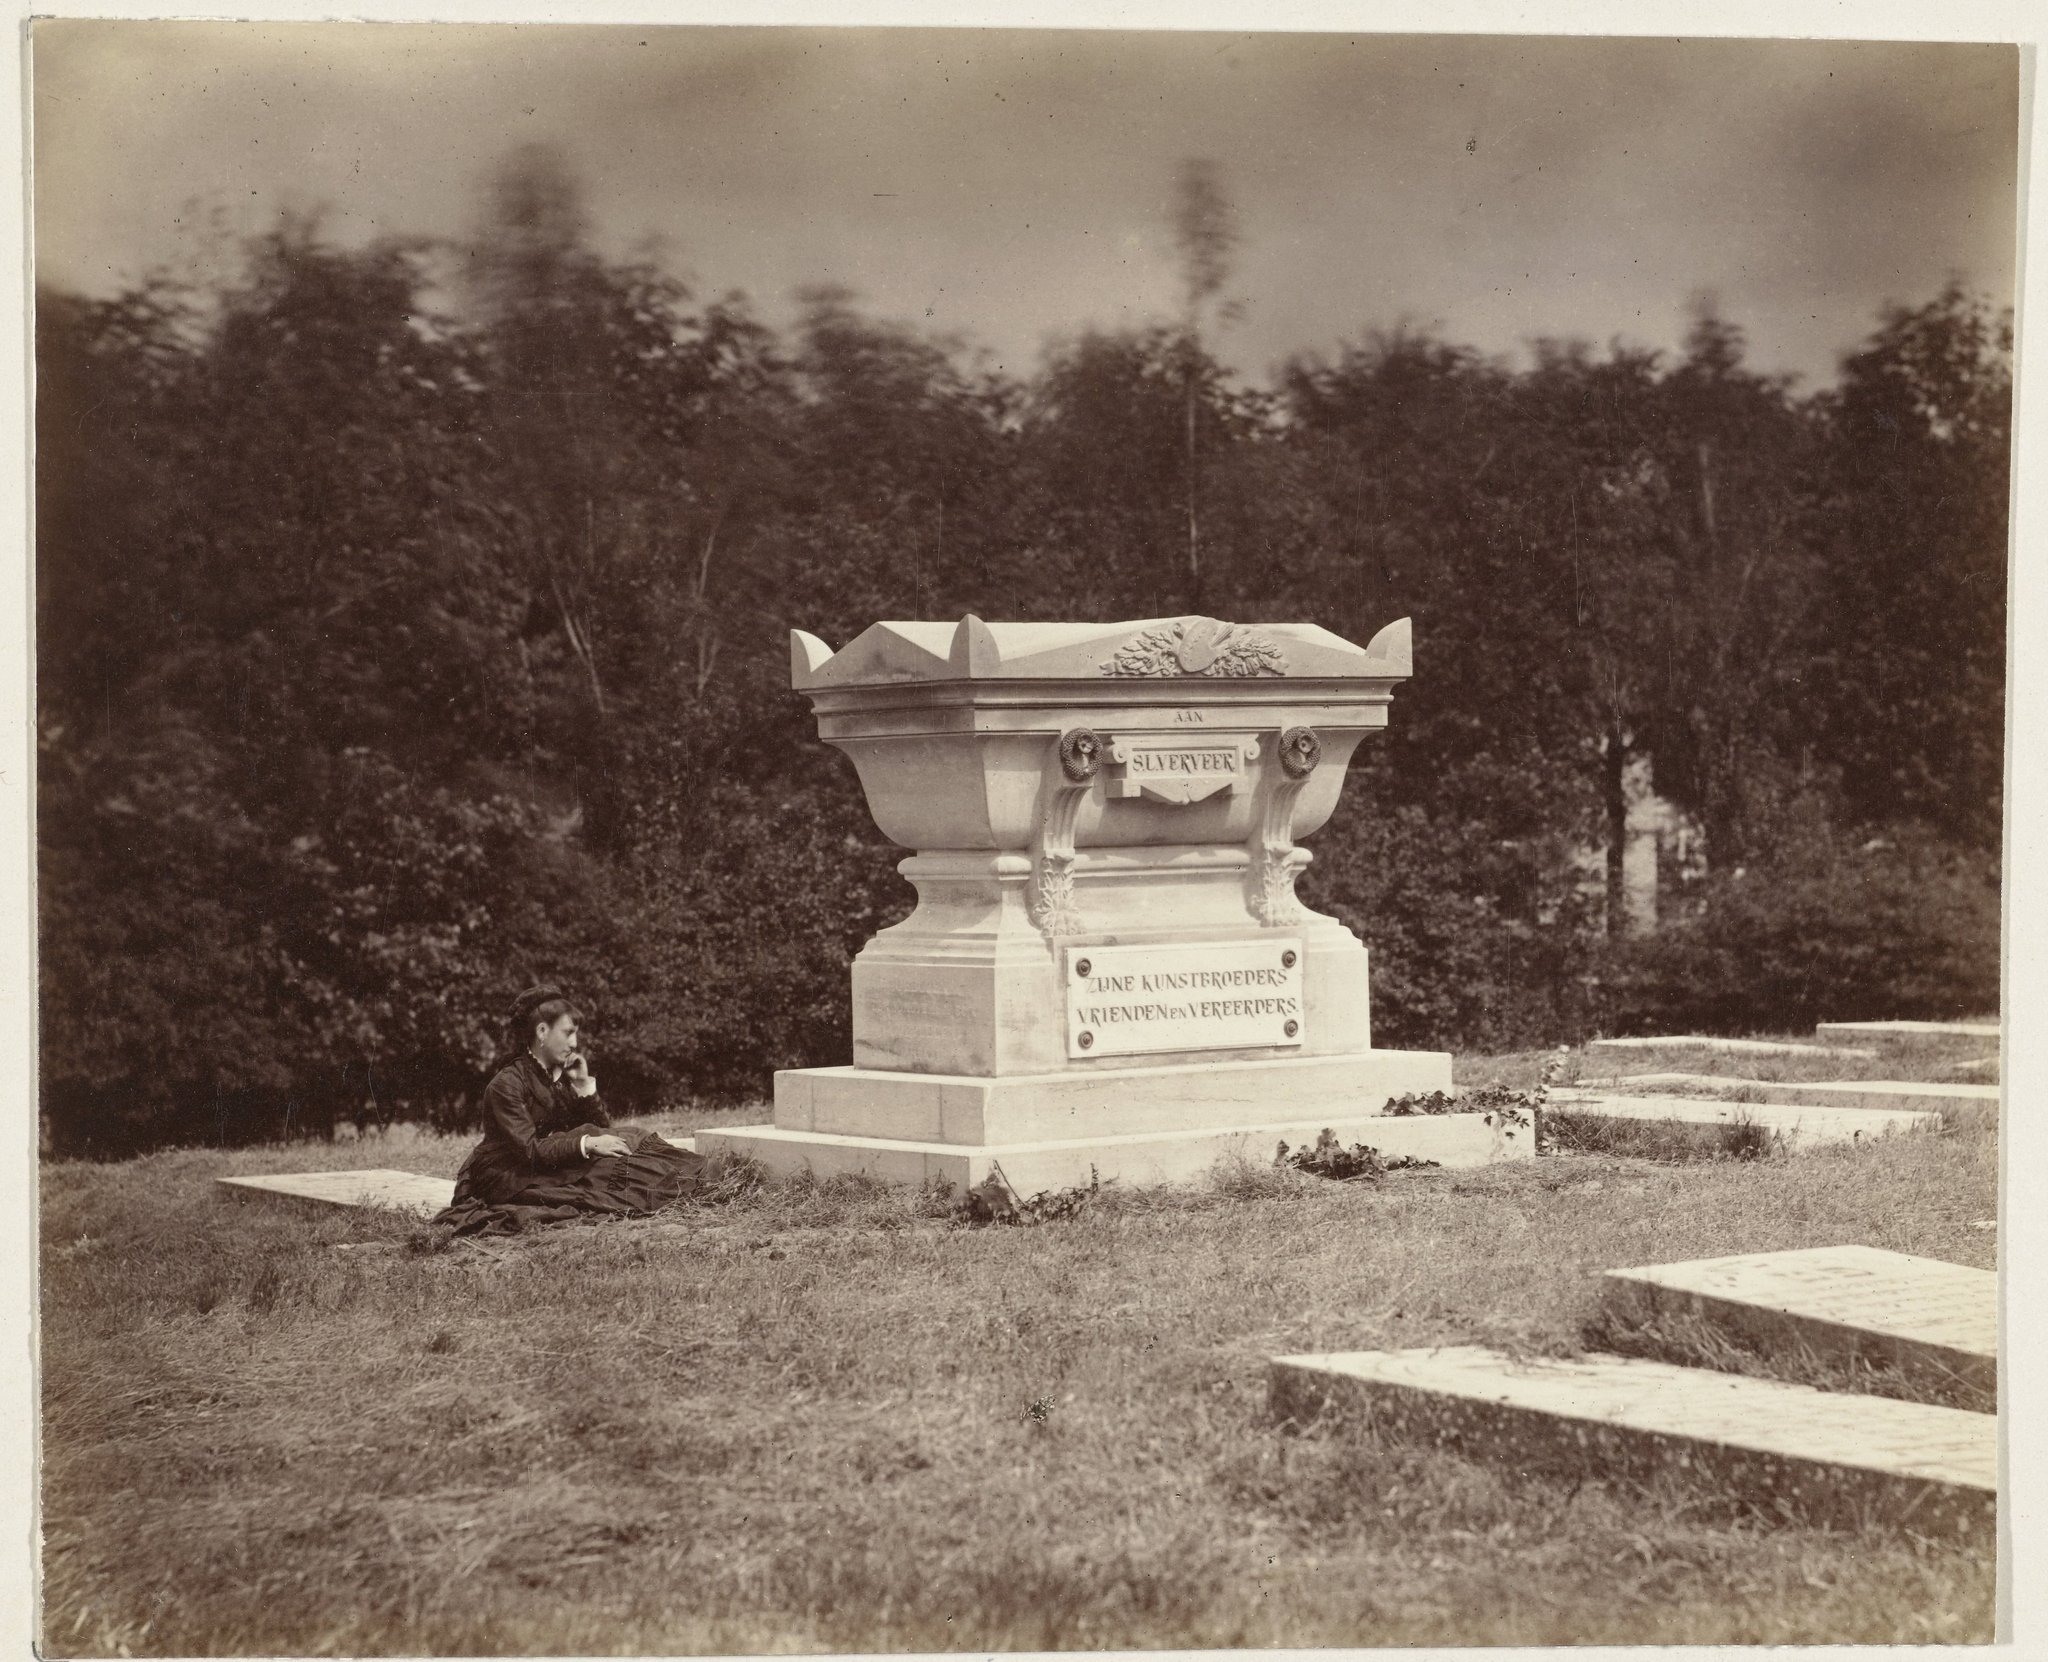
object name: photograph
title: Vrouw bij het grafmonument van Salomon Verveer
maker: maurits verveer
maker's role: painter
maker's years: 1817-1903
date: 1876-1880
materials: paper, photographic support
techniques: albumen print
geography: the hague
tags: the hague, salomon leonardus verveer, churchyard, cemetery, care and visitation of burial place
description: Het monument bvindt zich op de joodse begraafplaats aan de Scheveningseweg in Den Haag